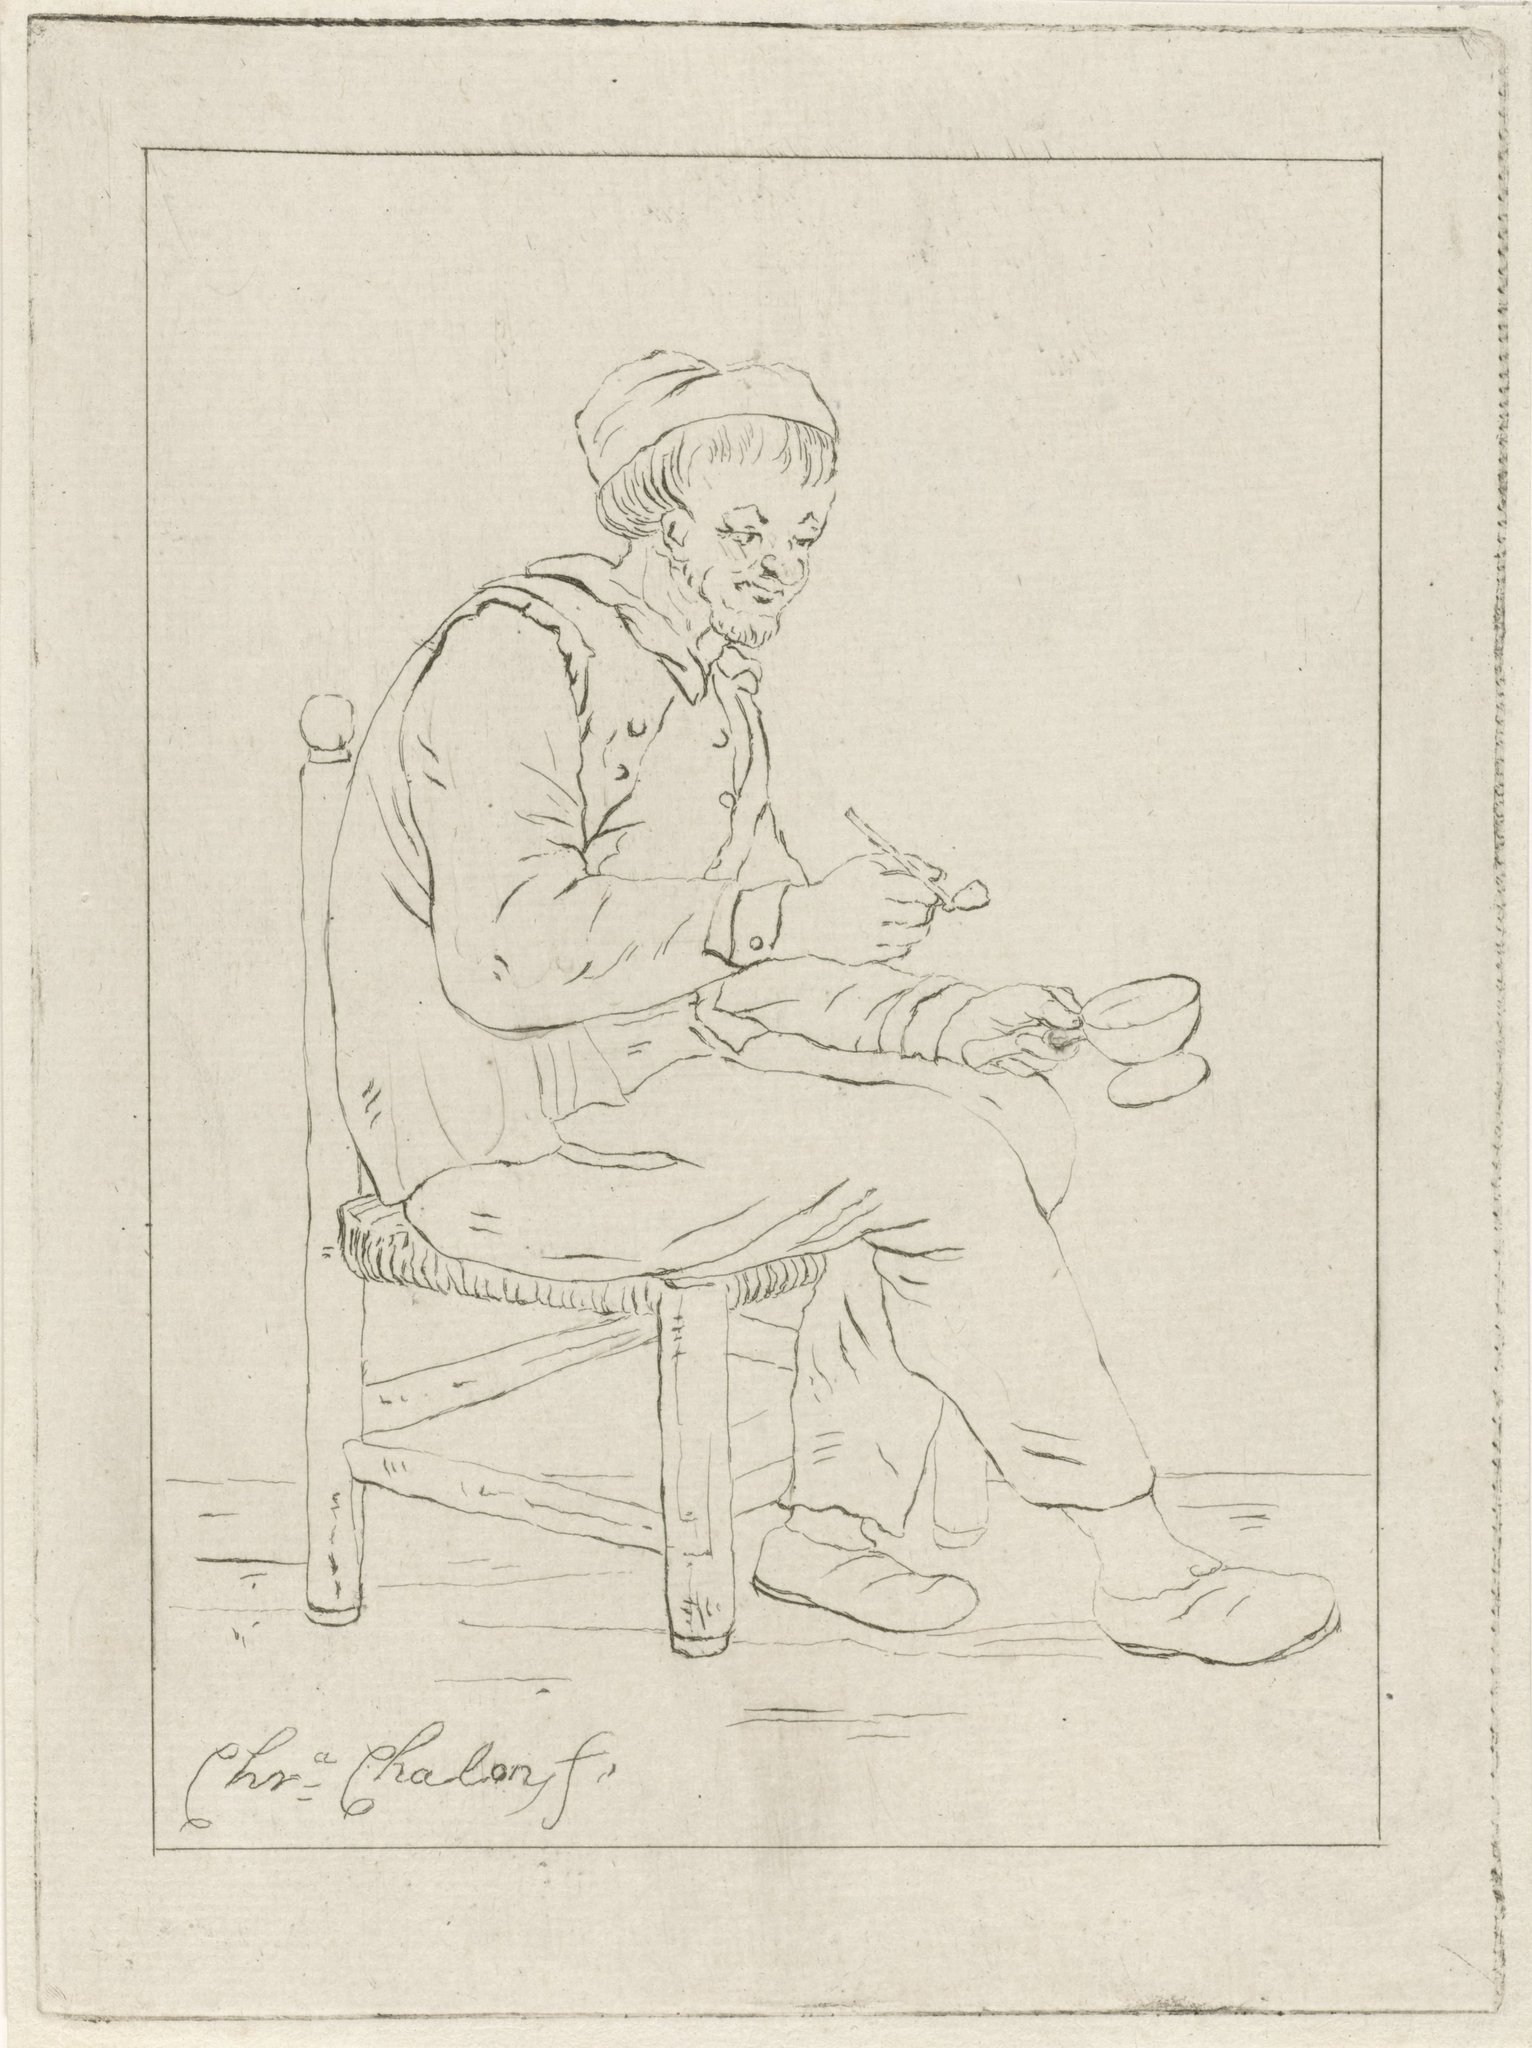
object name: print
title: Zittende pijproker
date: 1779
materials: paper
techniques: etching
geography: leiden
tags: sitting figure, pipe ~ tobacco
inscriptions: collector's mark: Lugt 240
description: Een man met een pijp zittend op een stoel. In zijn hand heeft hij een test met een kooltje vuur.